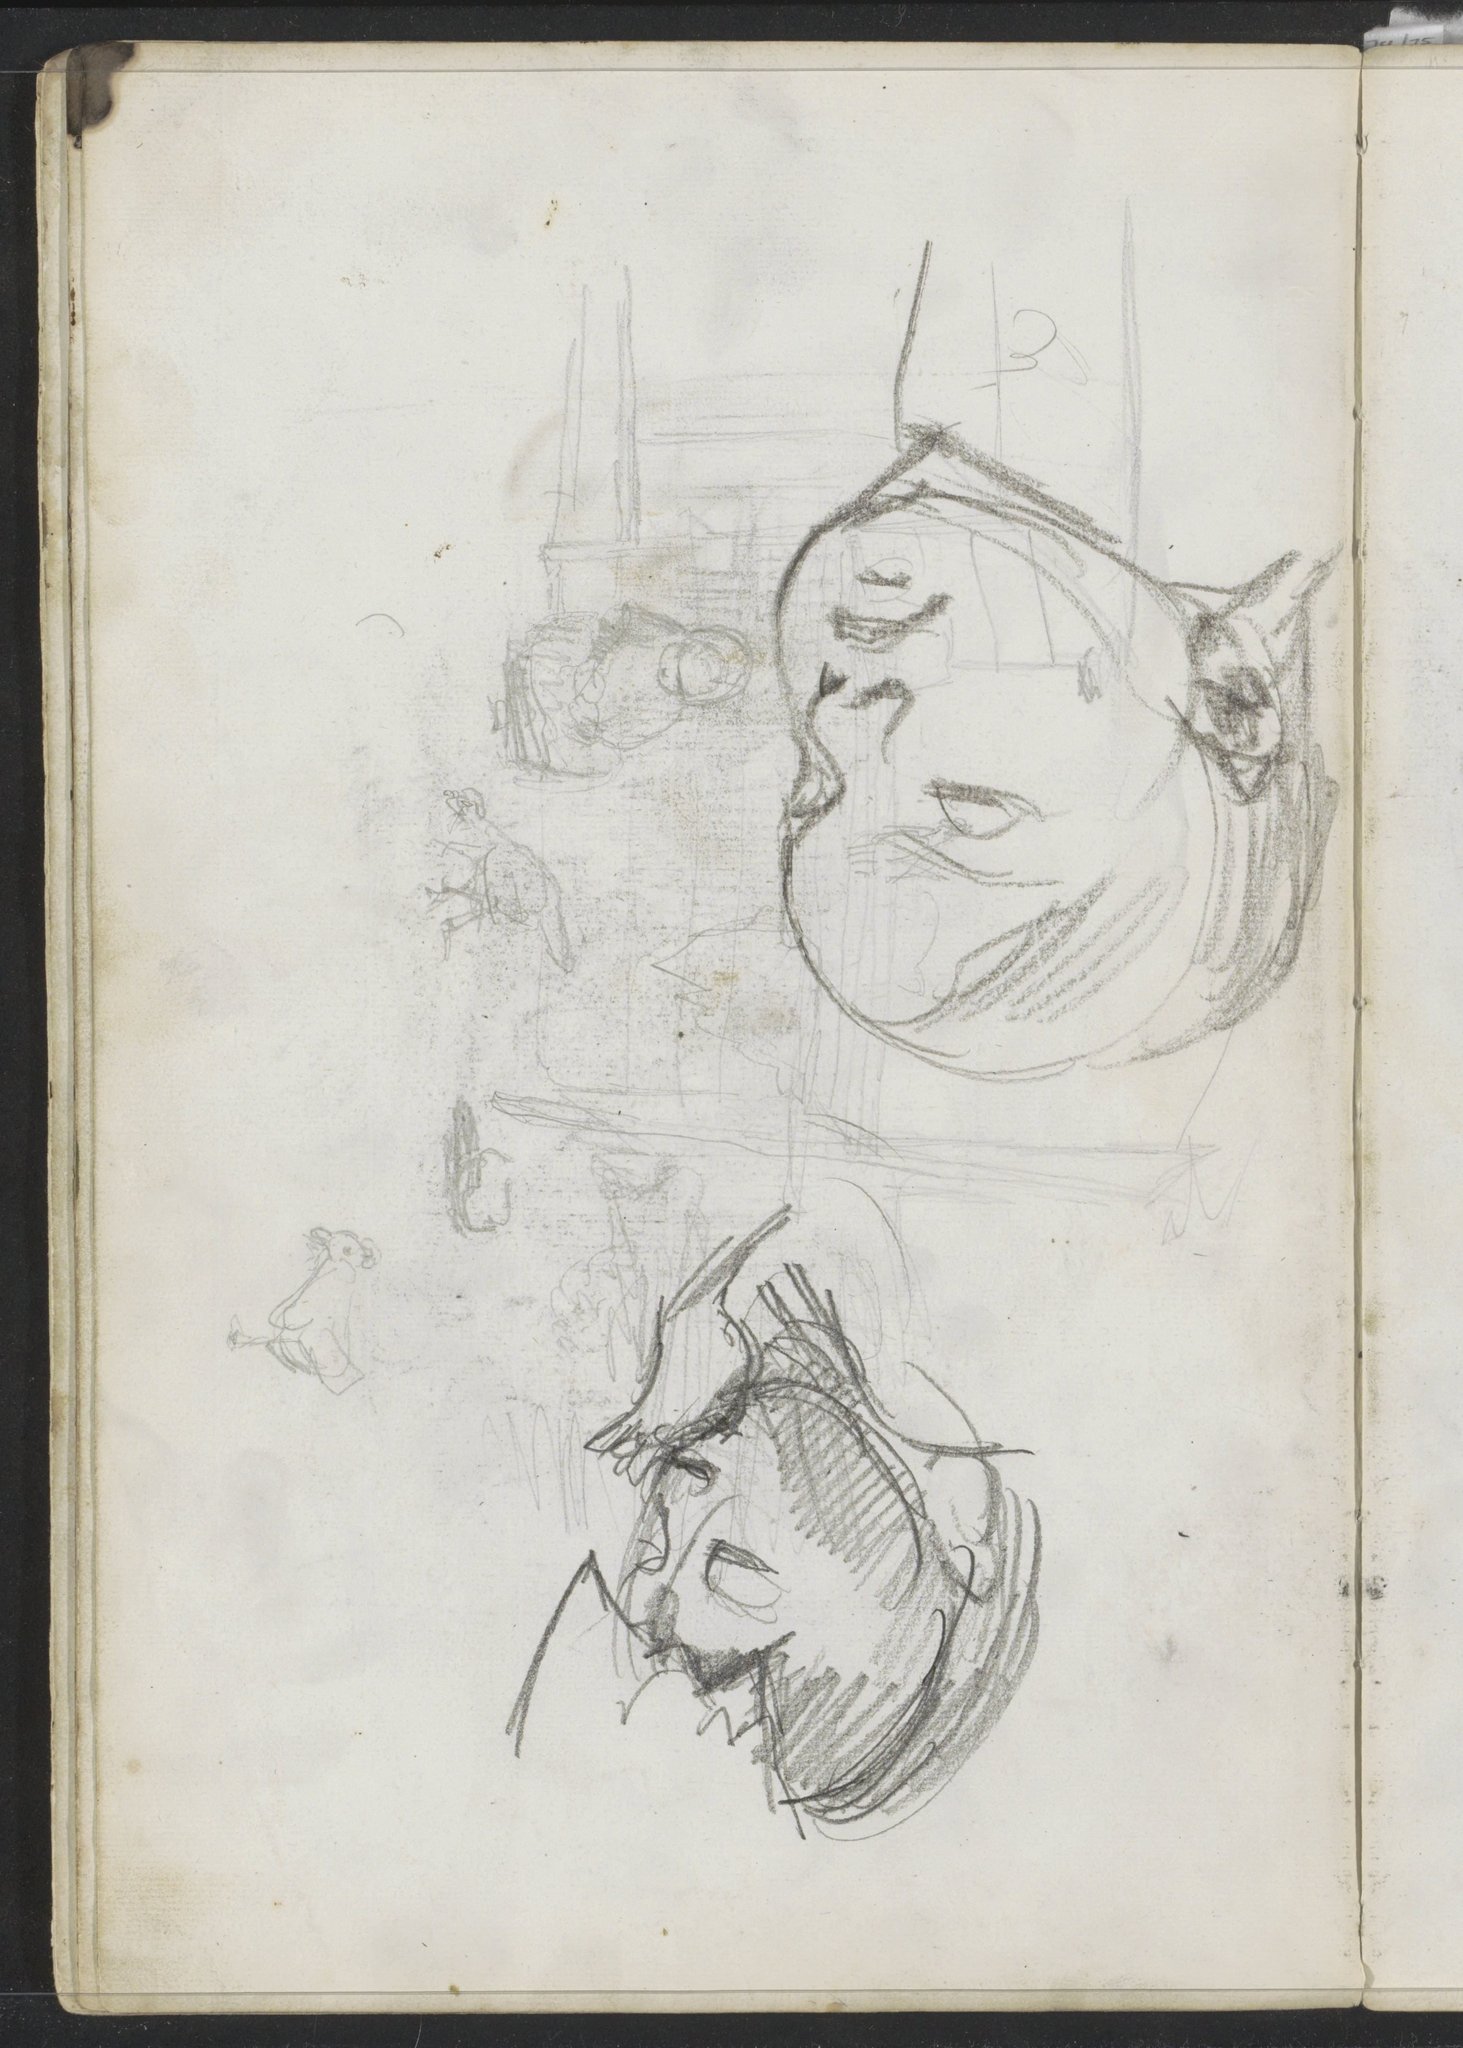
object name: sketchbook leaf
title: Twee koppen van kinderen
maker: jozef israëls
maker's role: draughtsman, painter, print maker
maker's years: 1824-1911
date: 1855-1859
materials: chalk, paper, pencil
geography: zandvoort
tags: head (human), thumb-sucking, fowl (cock, hen, chicken, etc.)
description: Eén kind heeft mogelijk een duim in de mond. Tevens een studie van een meisje zittend op een stoep met daarnaast scharrelende kippen. Blad 10 verso uit een schetsboek met 22 bladen.